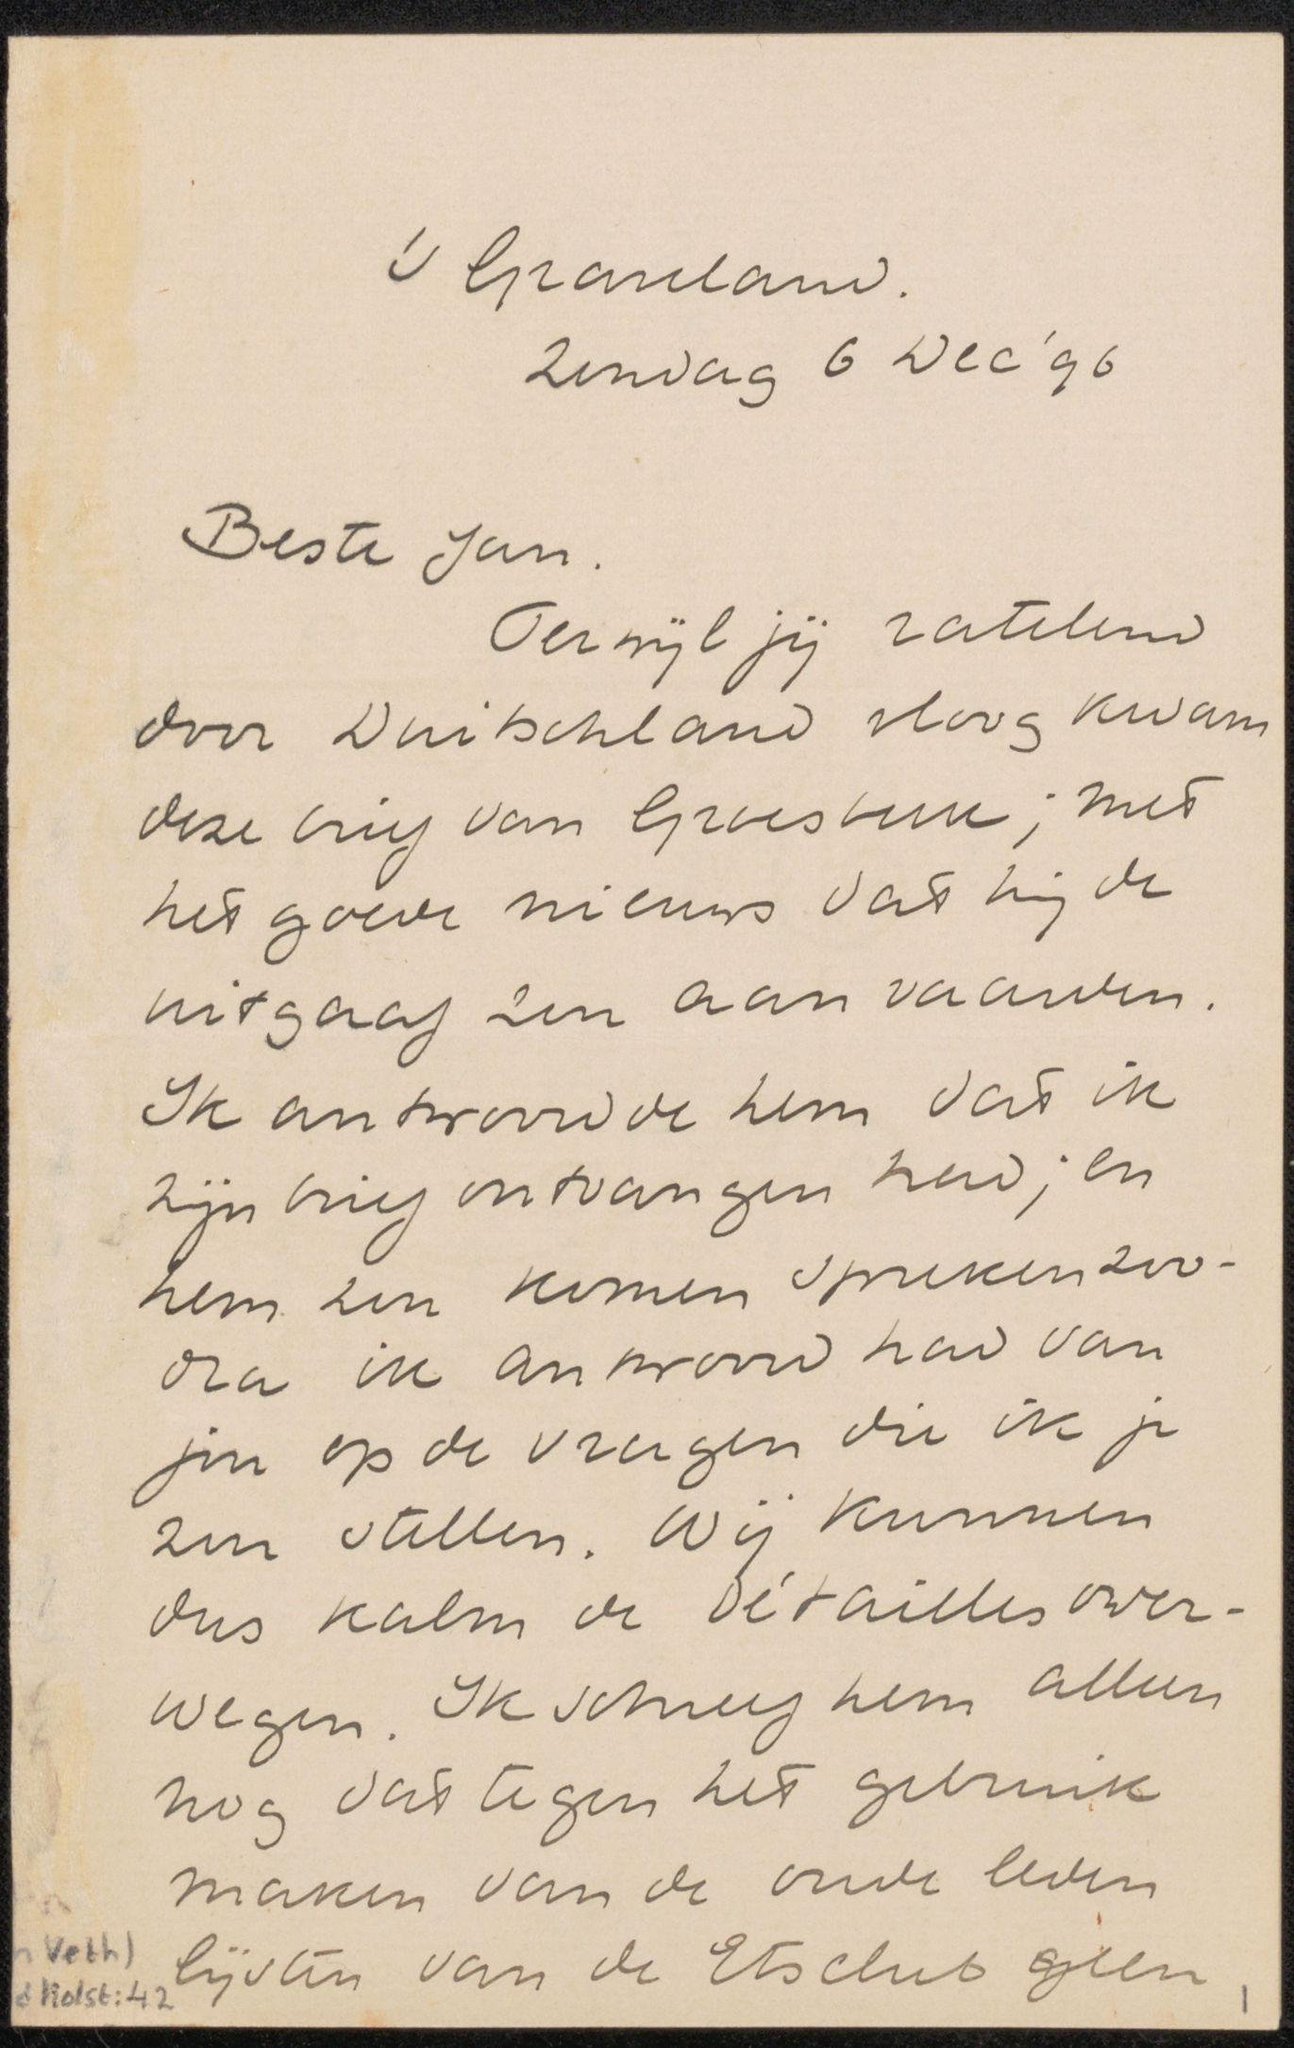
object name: letter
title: Brief aan Jan Veth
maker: richard nicolaüs roland holst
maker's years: 1868-1938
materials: ink, paper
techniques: pen, writing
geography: s-graveland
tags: designer, jan veth, marius bauer, klaas groesbeek, amsterdam, painter, draughtsman, cornelis gerardus 't hooft, publisher, philip zilcken, drawing, the graphic arts, money, printed matter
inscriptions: watermark, collector's mark: ‘RPK’